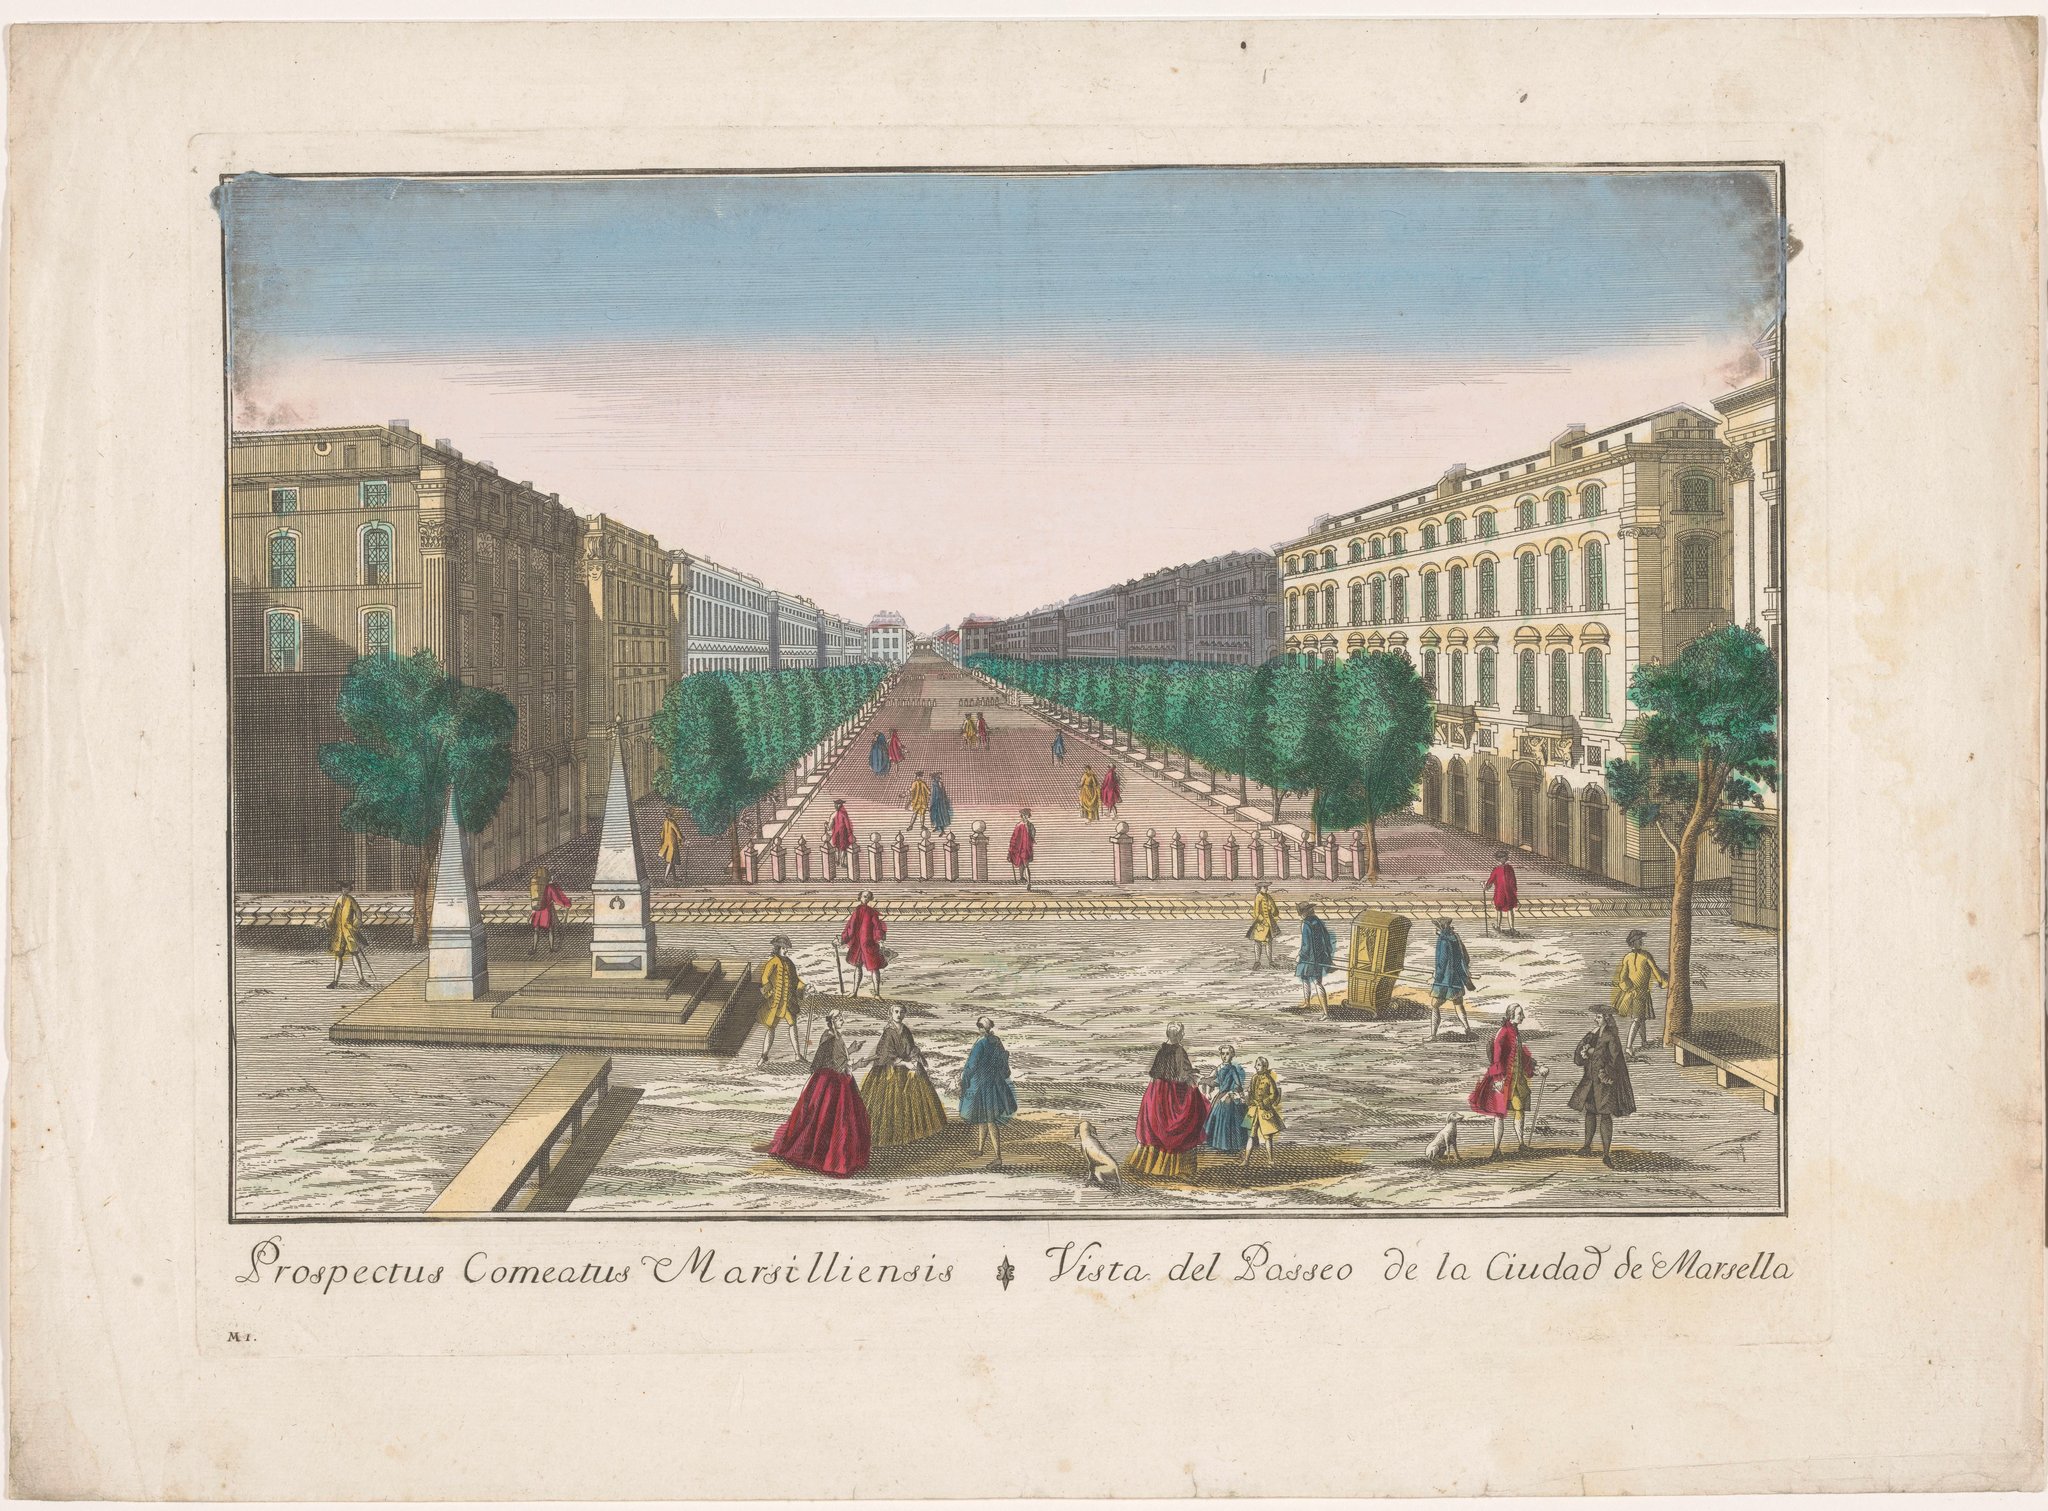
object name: opticaprent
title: Vista del passeo de la ciudad de Marsella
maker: Anonymous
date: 1700-1799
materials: paper, watercolor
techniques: brush, etching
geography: italy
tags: avenue, boulevard, promenade, esplanade (+ city(-scape) with figures, staffage), marseille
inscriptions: collector's mark: Lugt 2228